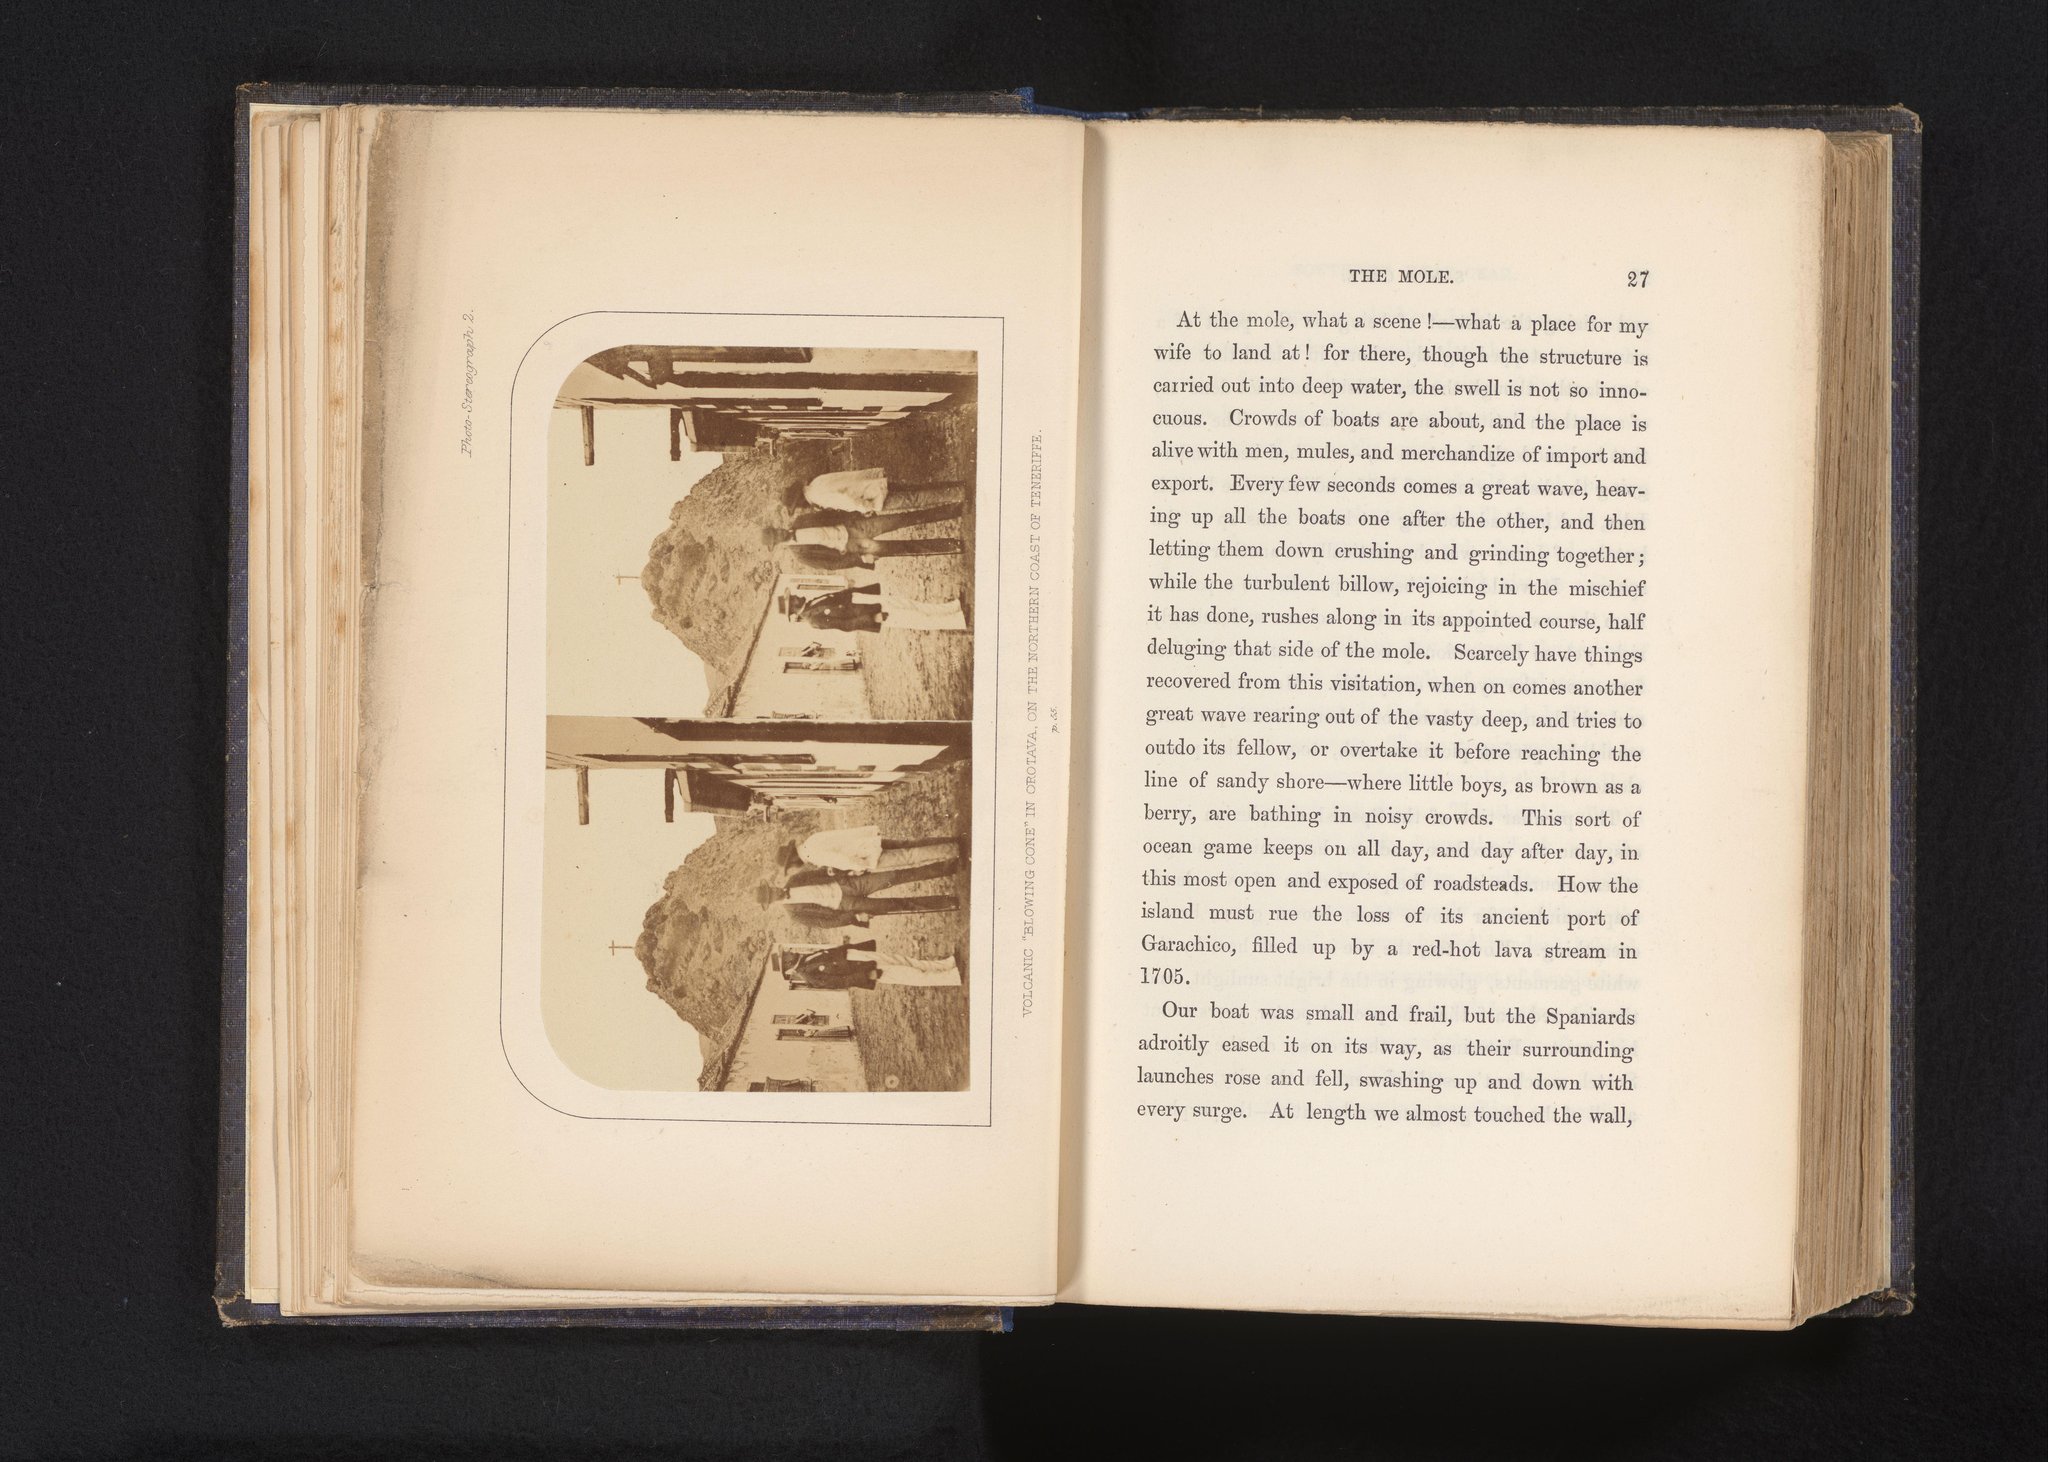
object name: page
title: Volcanic "Blowing Cone" in Orotava, on the northern coast of Teneriffe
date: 1856-1858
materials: paper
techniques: albumen print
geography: london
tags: volcanic formations, street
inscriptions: inscription: ‘Photo-Stereograph 2.’